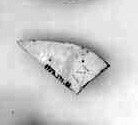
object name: shard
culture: korean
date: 1401-1500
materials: pottery